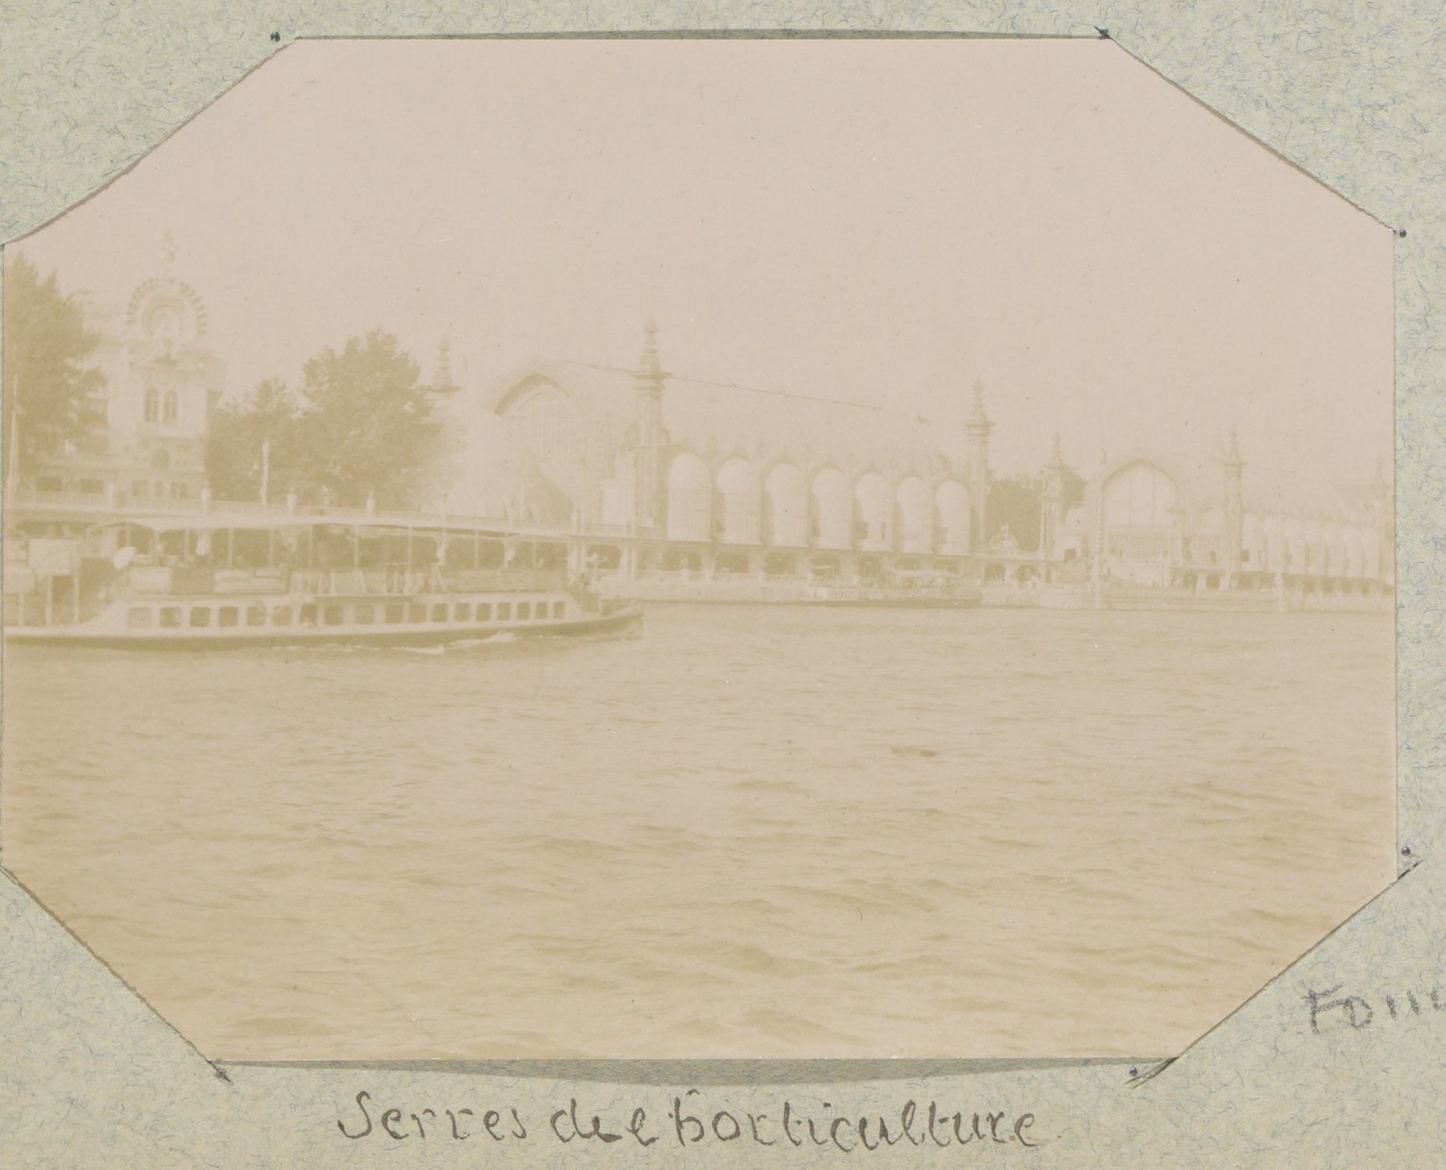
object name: album leaf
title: Gezicht op een Seinekade met de serres van het Palais de l'Horticulture tijdens de Wereldtentoonstelling van 1900 in Parijs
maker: paul lucena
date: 1900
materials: paper, photographic support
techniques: daylight paper print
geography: paris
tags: world fair, world exhibition, palace, greenhouse, orangery, quay (+ city(-scape) with figures, staffage), paris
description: Onderdeel van Album van een Franse amateur met foto's van Frankrijk, Algerije, Palmyra, de Wereldtentoonstelling van 1900 en van bekende Fransen.